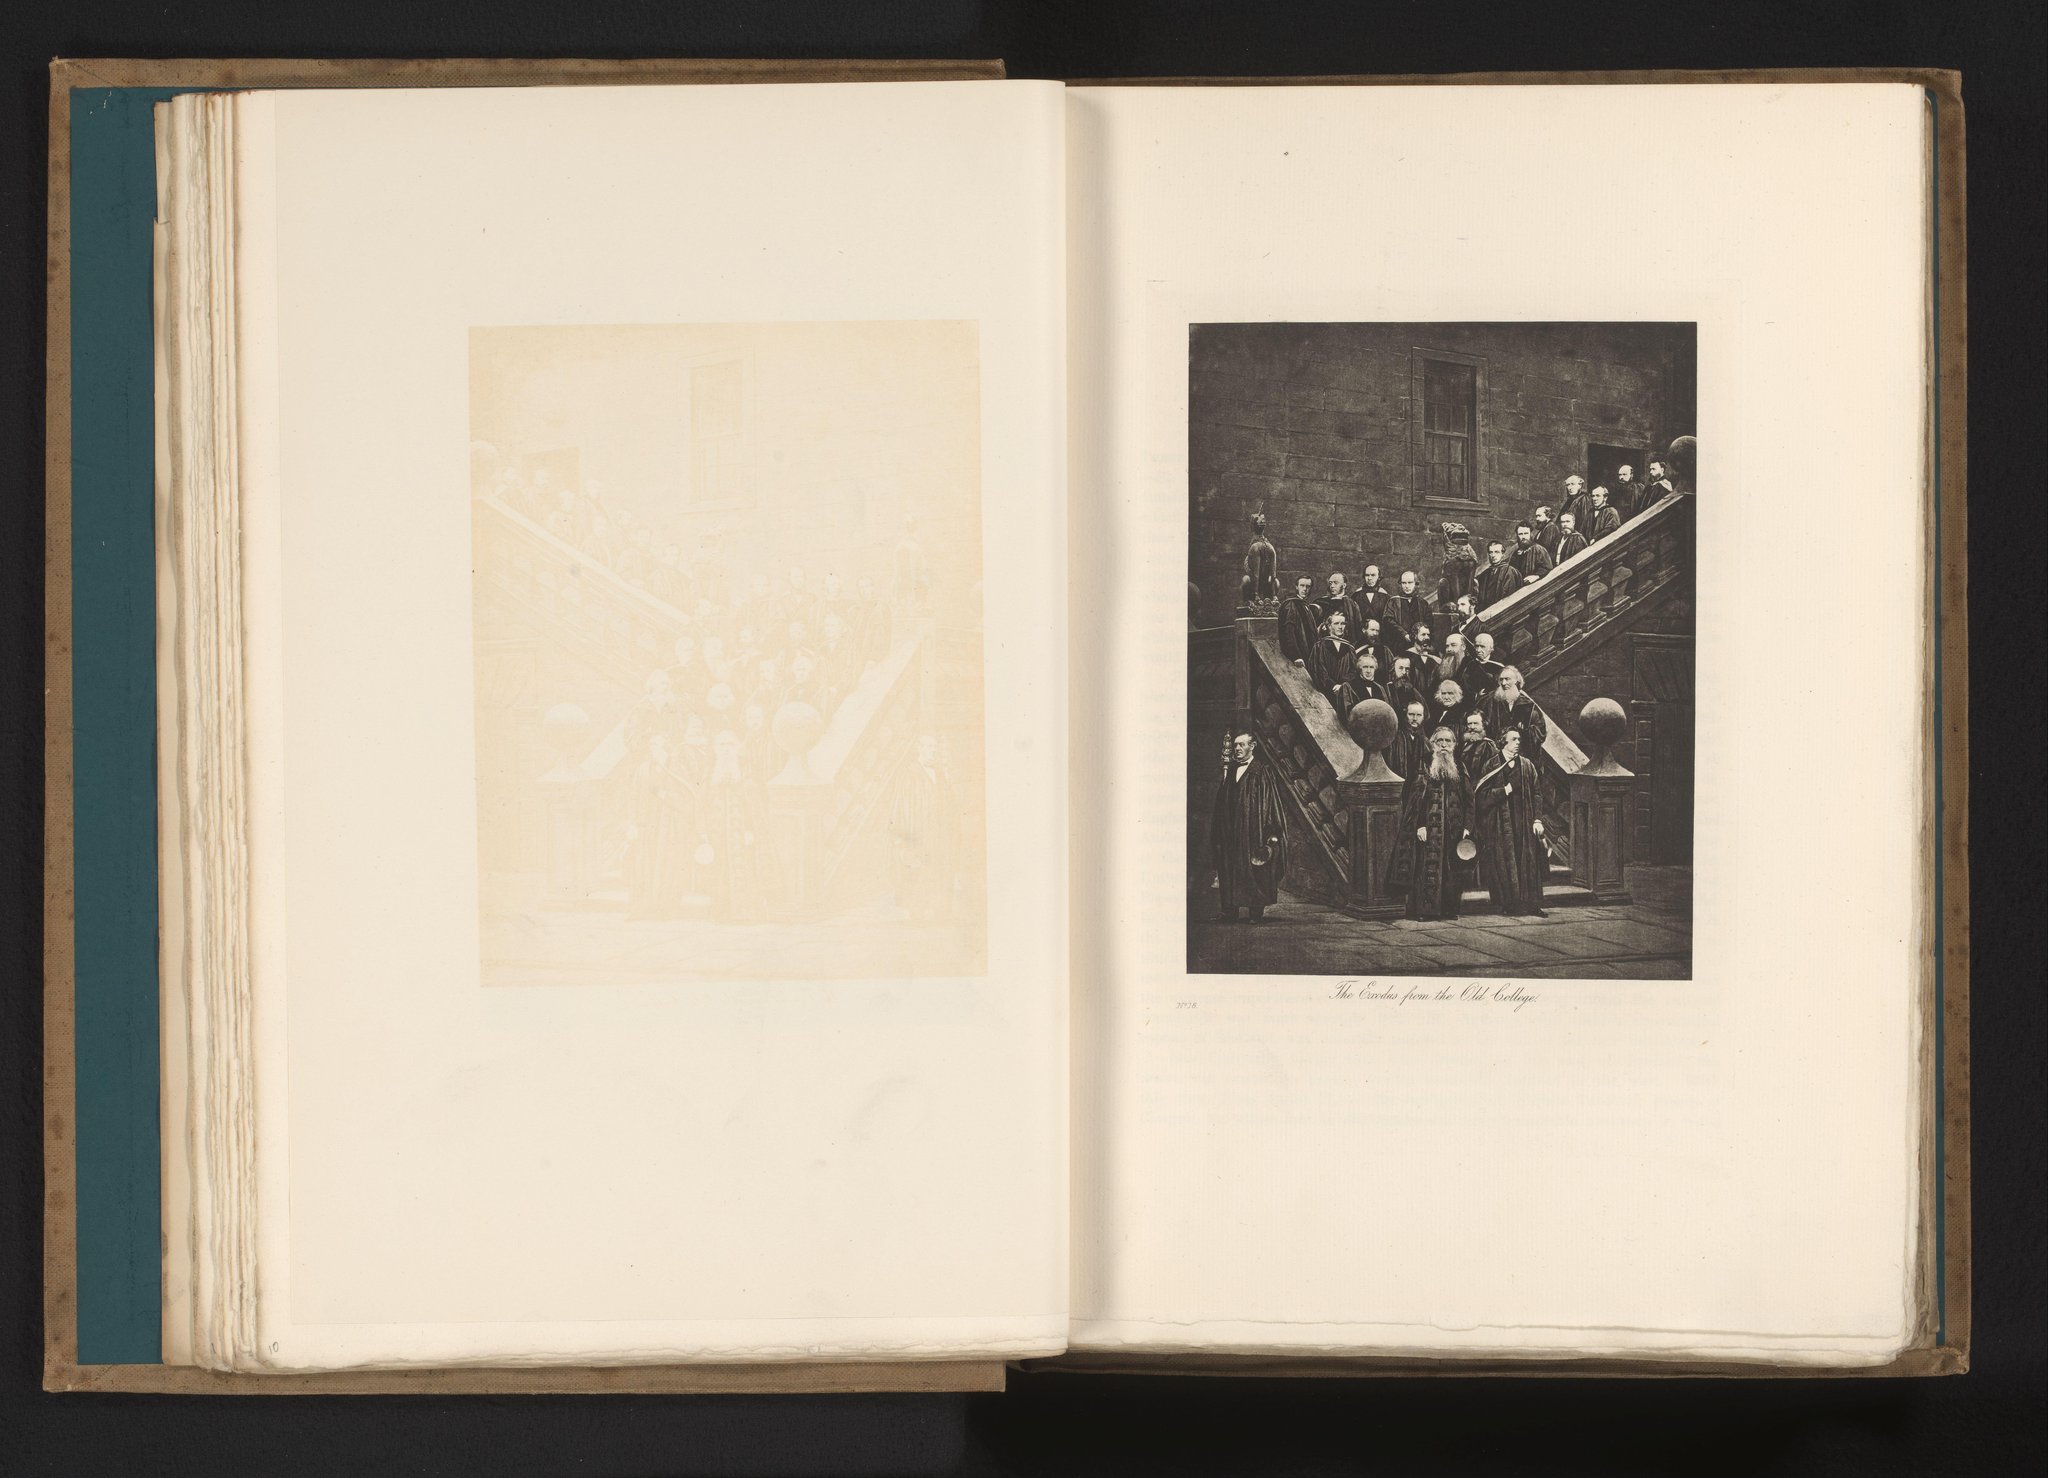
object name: photomechanical print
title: Professoren verlaten het oude universiteitsgebouw van de universiteit van Glasgow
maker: Anonymous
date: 1886-1891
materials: paper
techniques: photoaquatint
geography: glasgow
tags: university (+ teacher, professor), staircase, glasgow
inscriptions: inscription: ‘No.18’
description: Prent op negentiende ongenummerde pagina na pagina iv.